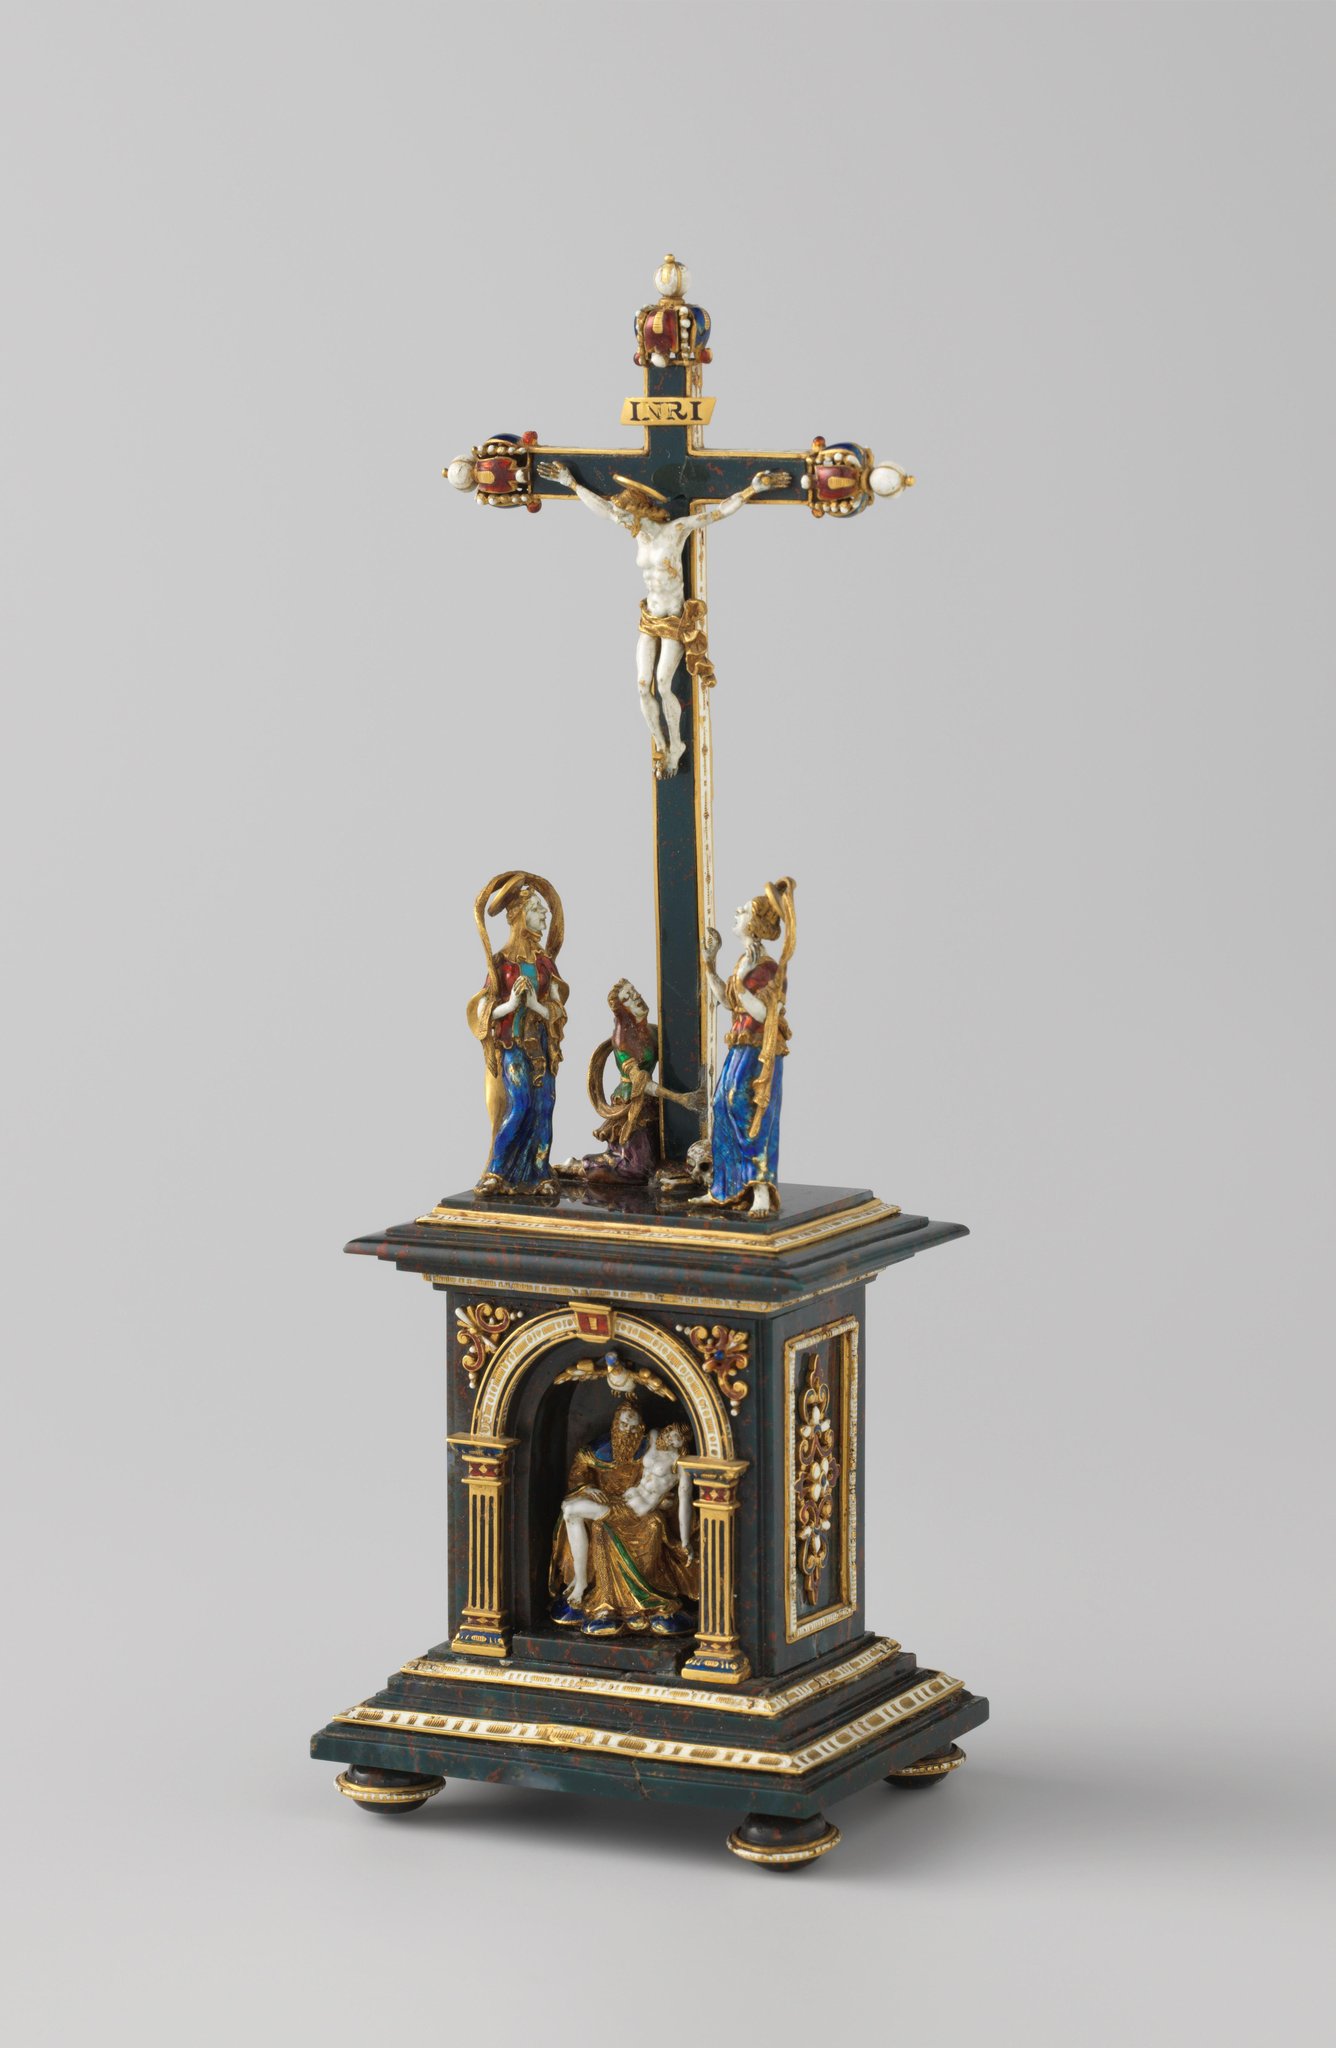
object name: cross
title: Kruis van lapis lazuli op een postament van bloedjaspis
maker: Anonymous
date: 1585-1600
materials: gold, jasper, lapis lazuli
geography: southern germany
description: Figuren en versieringen zijn van goud en email. Onderaan de kruisvoet, Christus en Maria, Maria Magdalena en Johannes. In een nis God, Christus en de H. Geest.